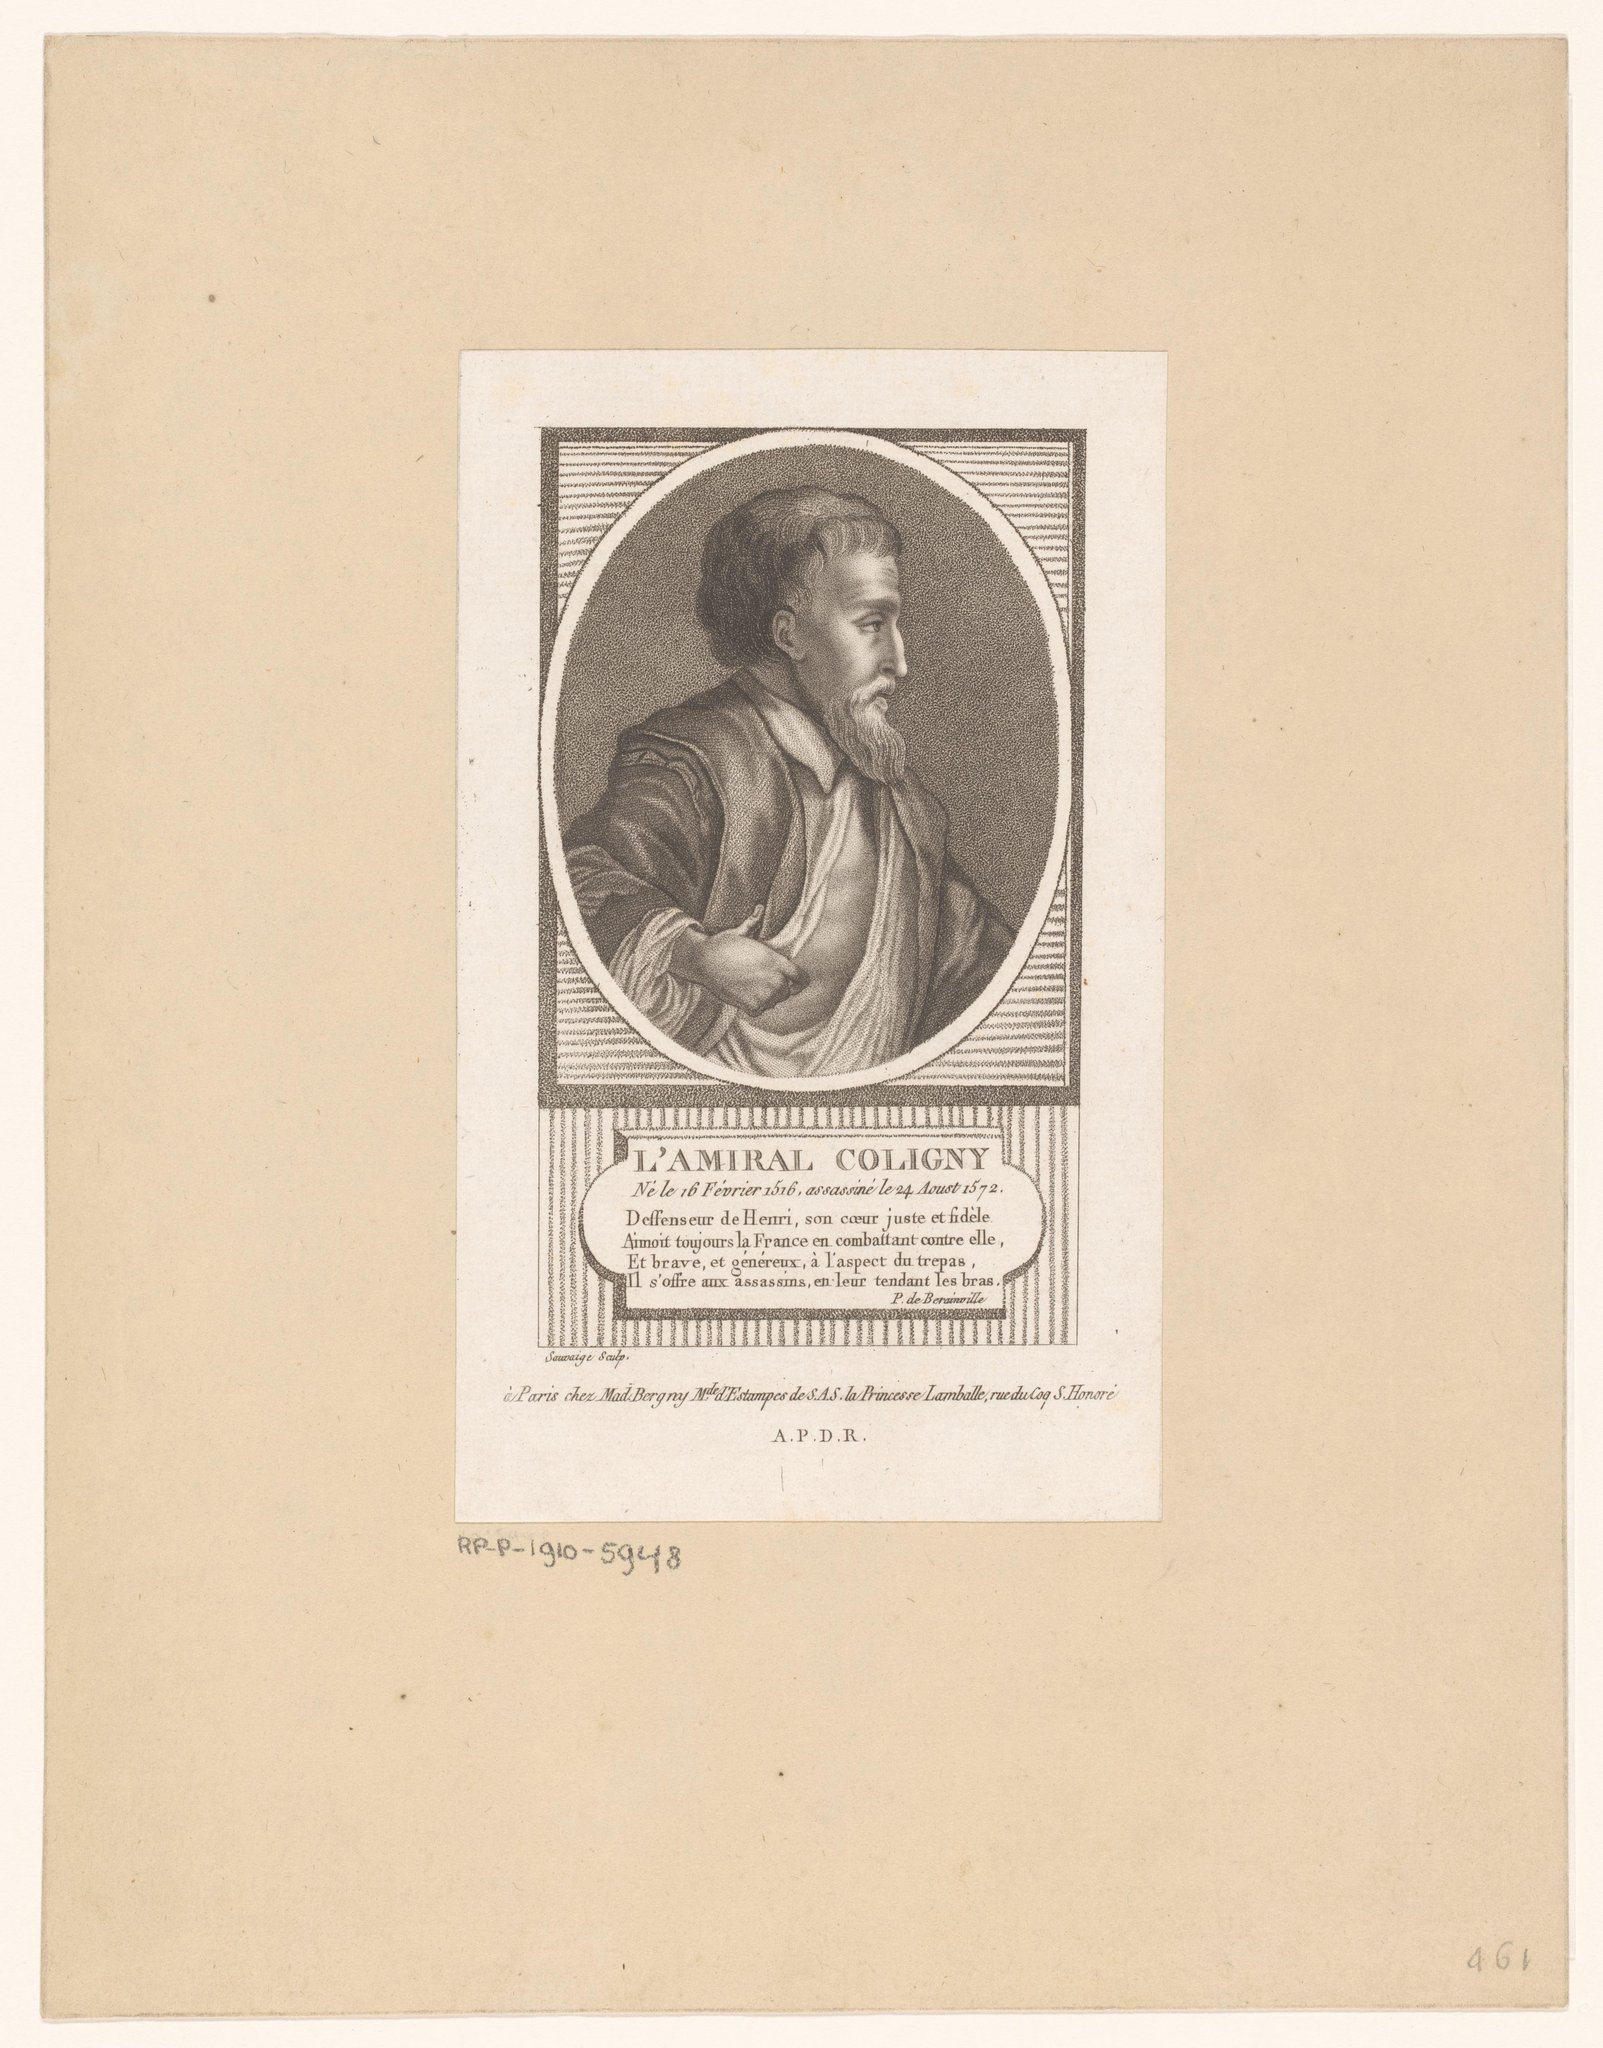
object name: print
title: Portret van Gaspard de Coligny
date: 1754-1818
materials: paper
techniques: etching, roulette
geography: paris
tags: paris, politician, gaspard de coligny (ii), historical persons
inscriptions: collector's mark: Lugt 2228